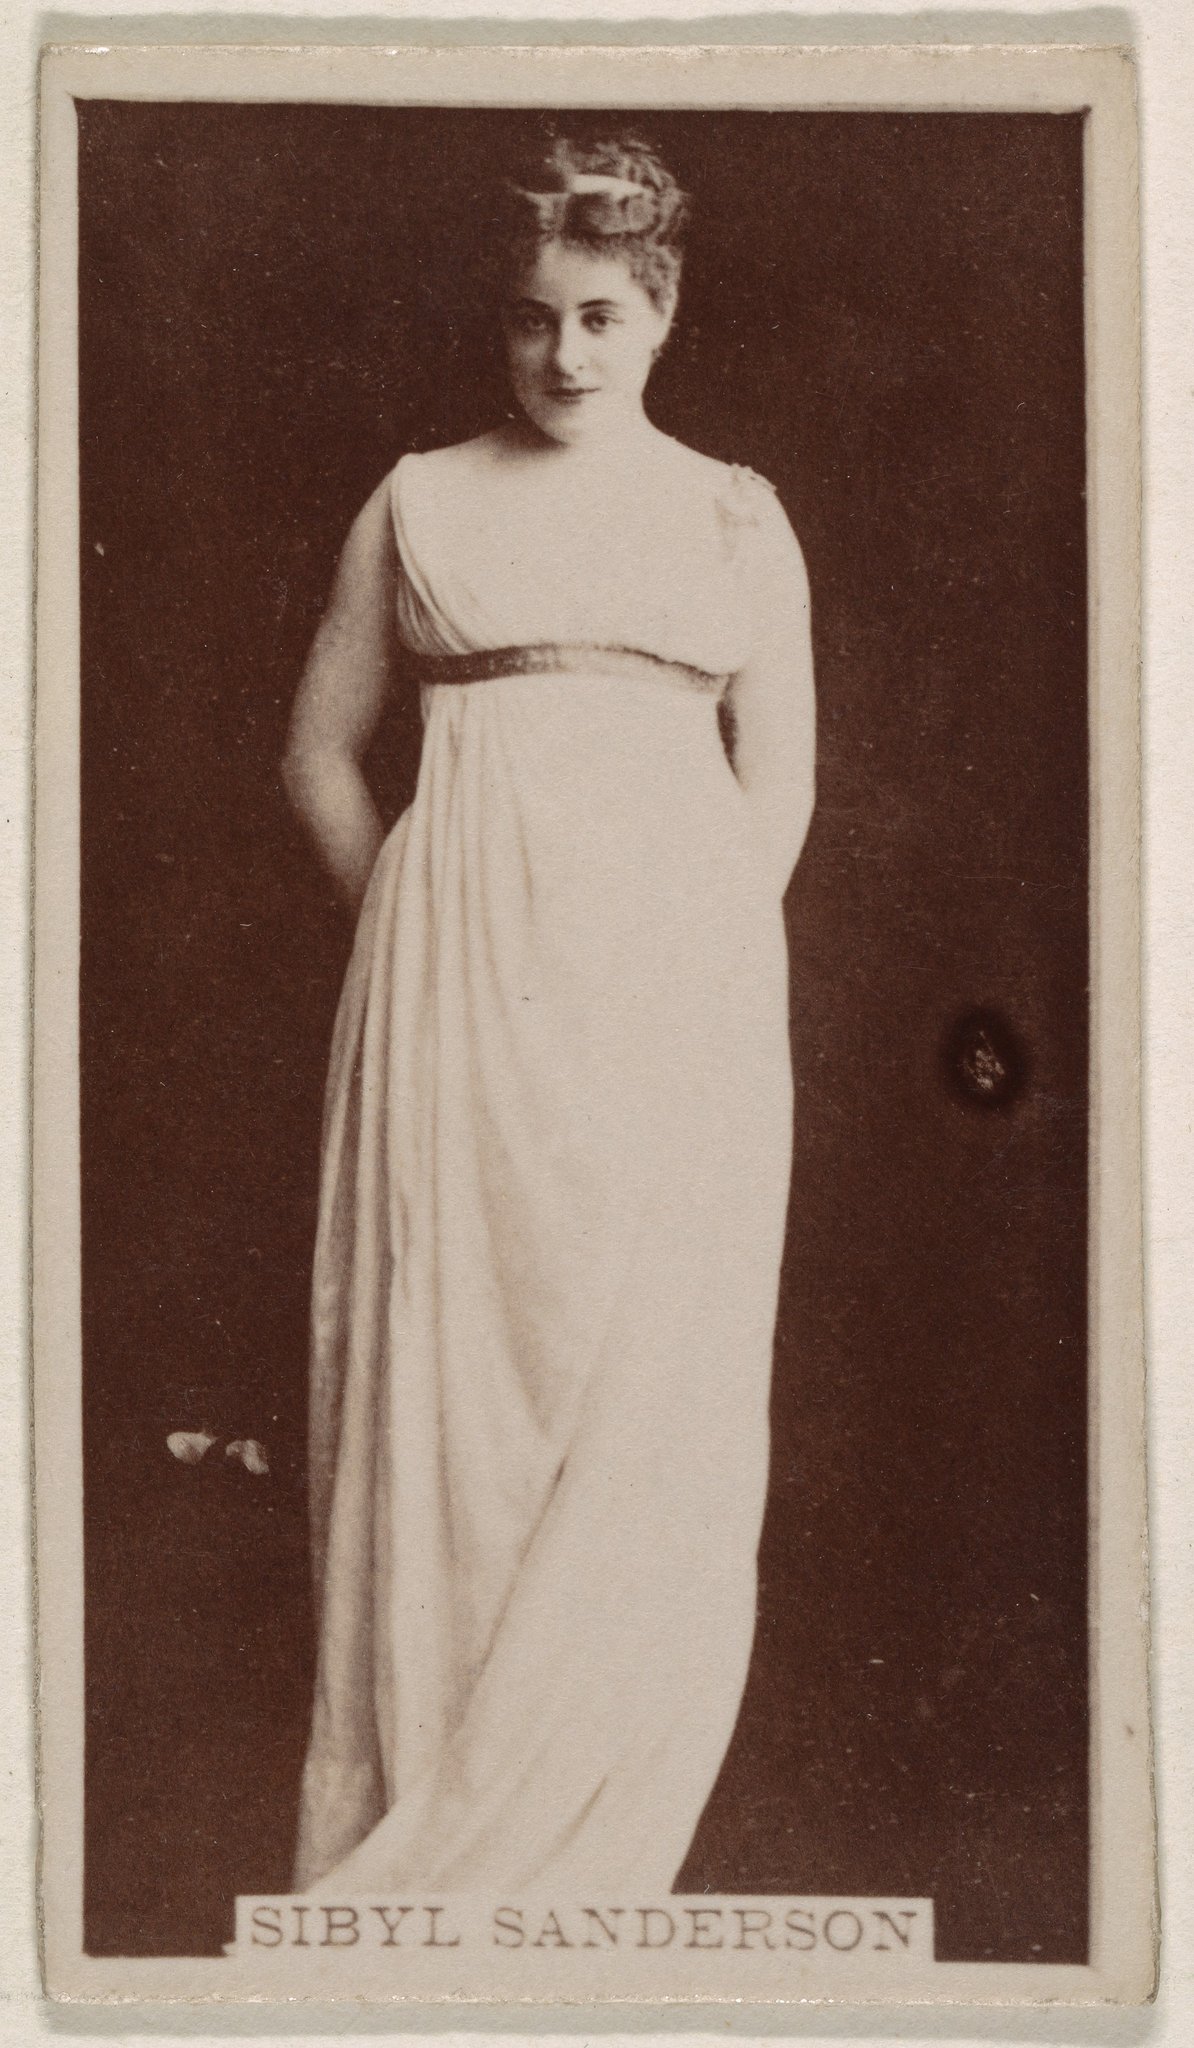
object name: photograph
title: Sibyl Anderson, from the Actresses series (N245) issued by Kinney Brothers to promote Sweet Caporal Cigarettes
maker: kinney brothers tobacco company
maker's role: publisher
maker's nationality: american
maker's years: 1869-2011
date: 1890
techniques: albumen silver print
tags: portraits,women,actresses